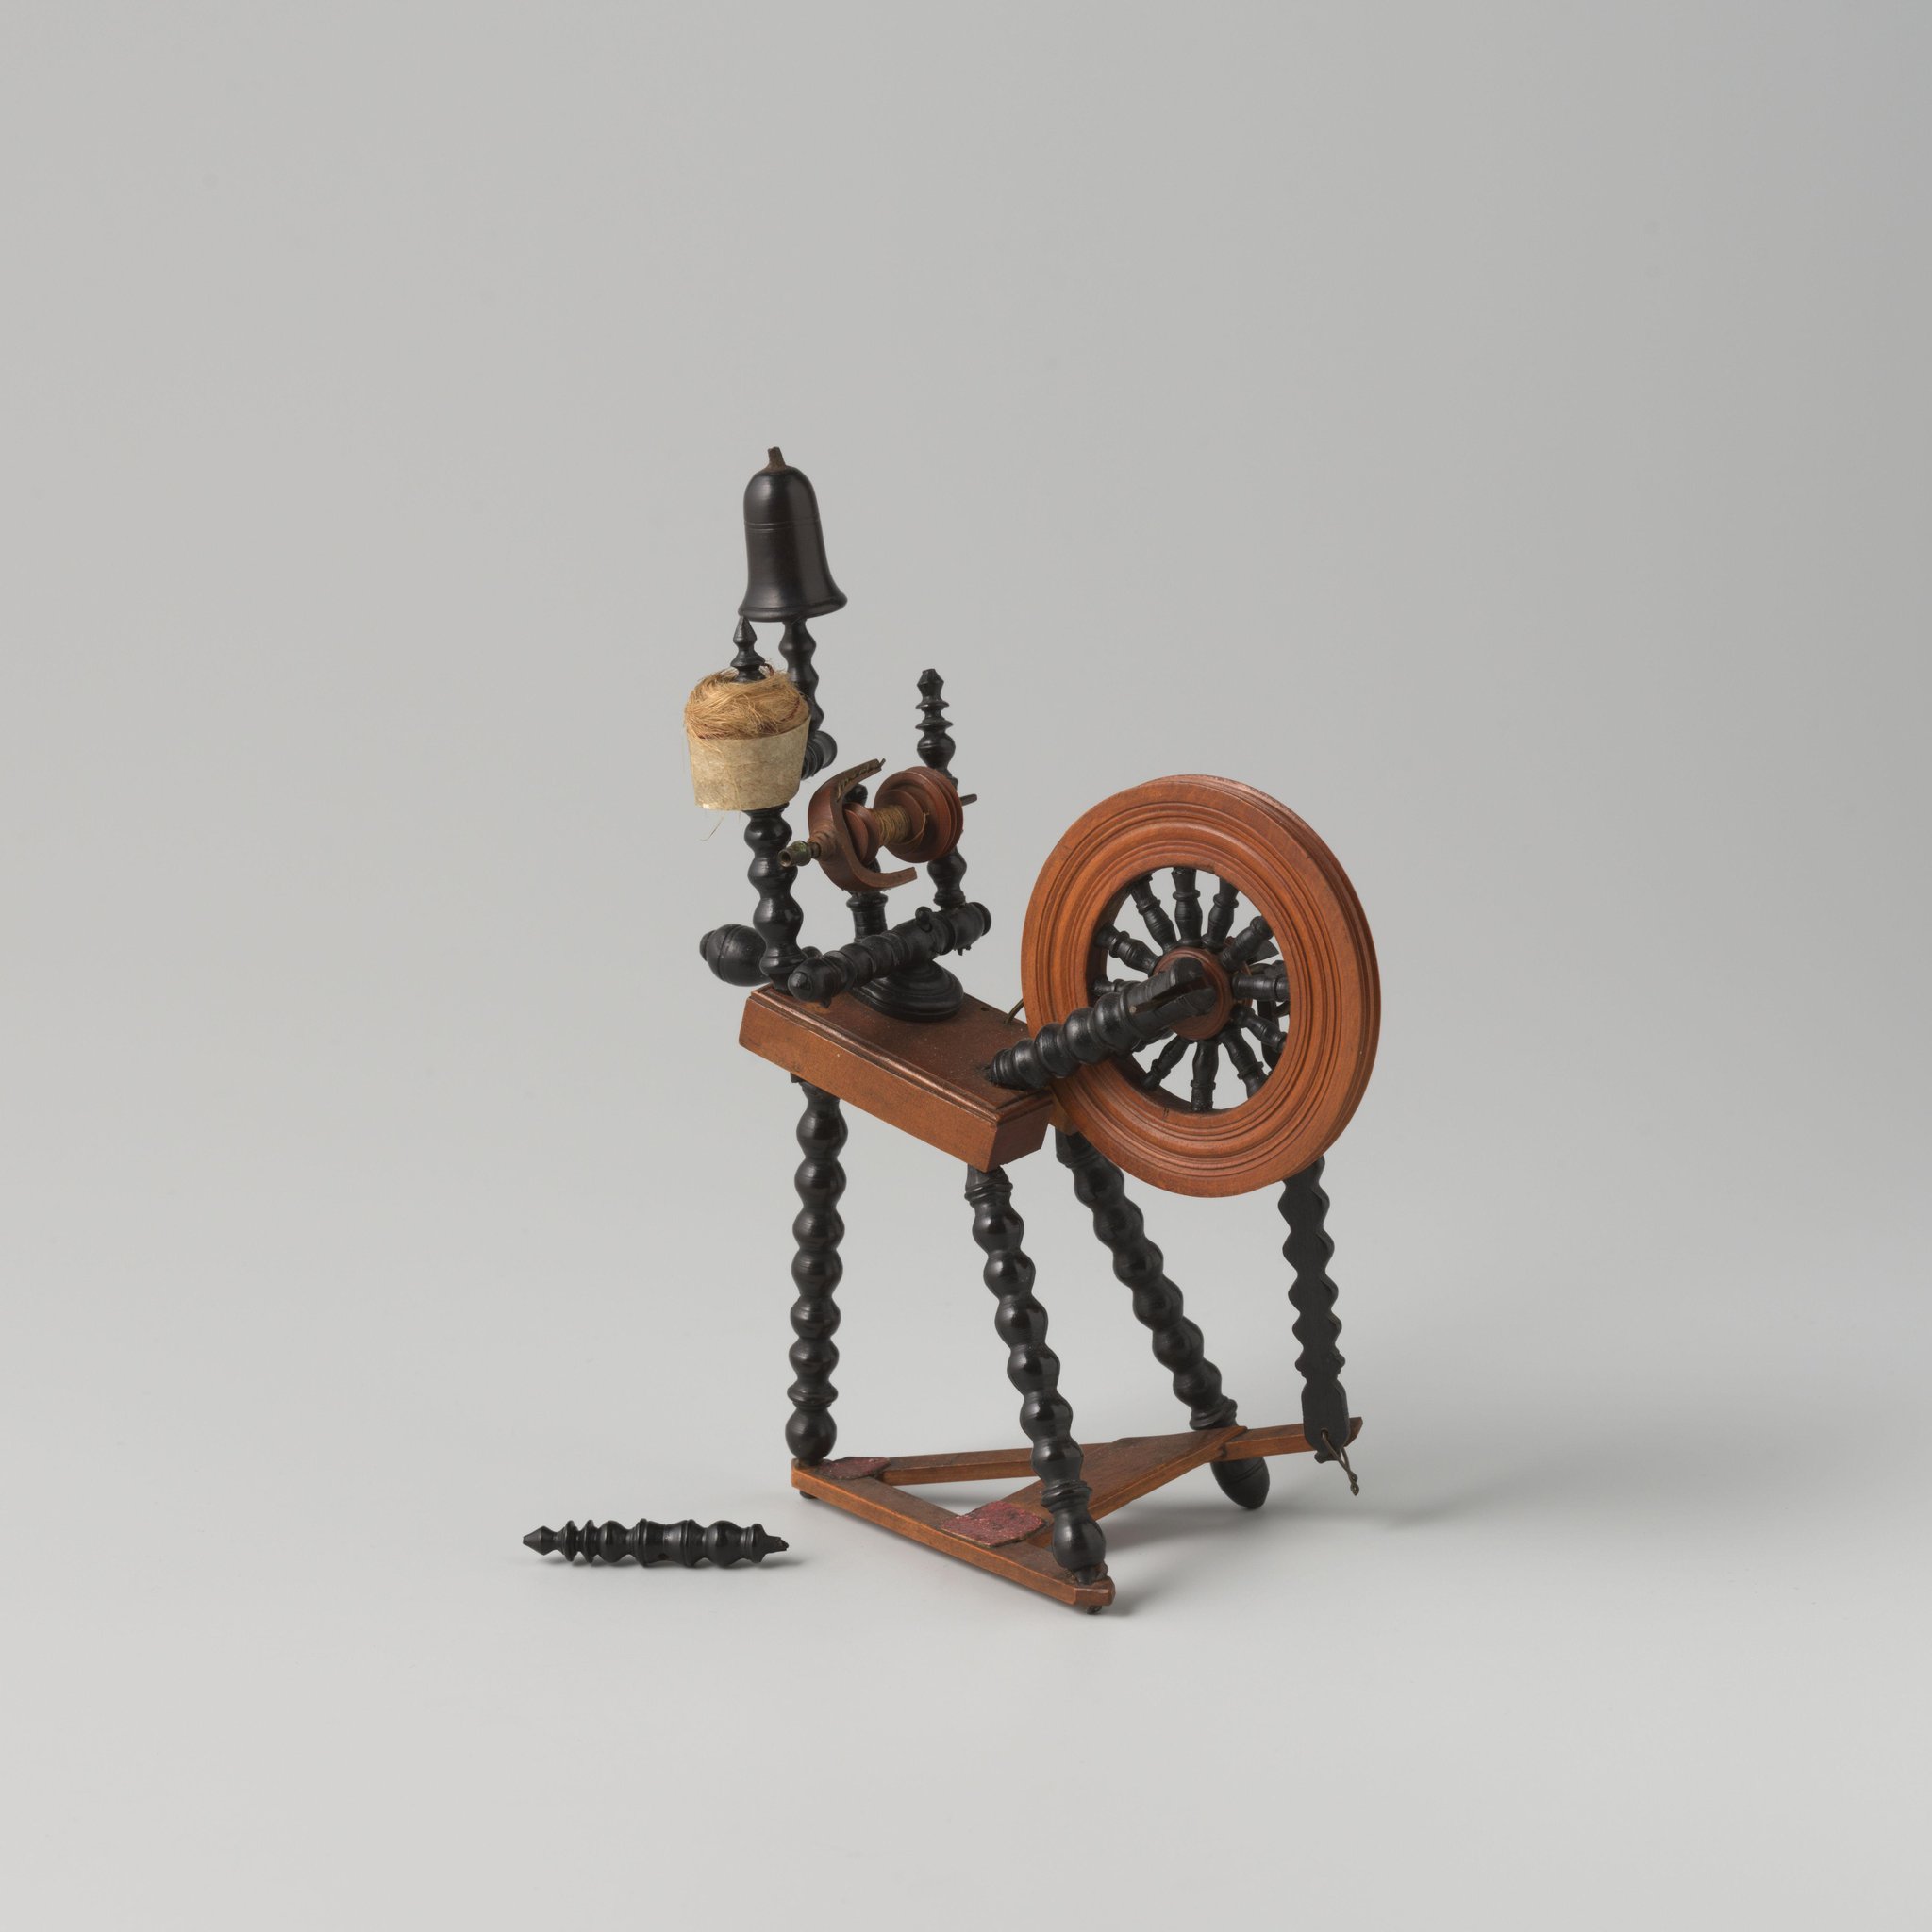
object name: spinning wheel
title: Spinnewiel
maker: Anonymous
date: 1690-1710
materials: wood, leather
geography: amsterdam